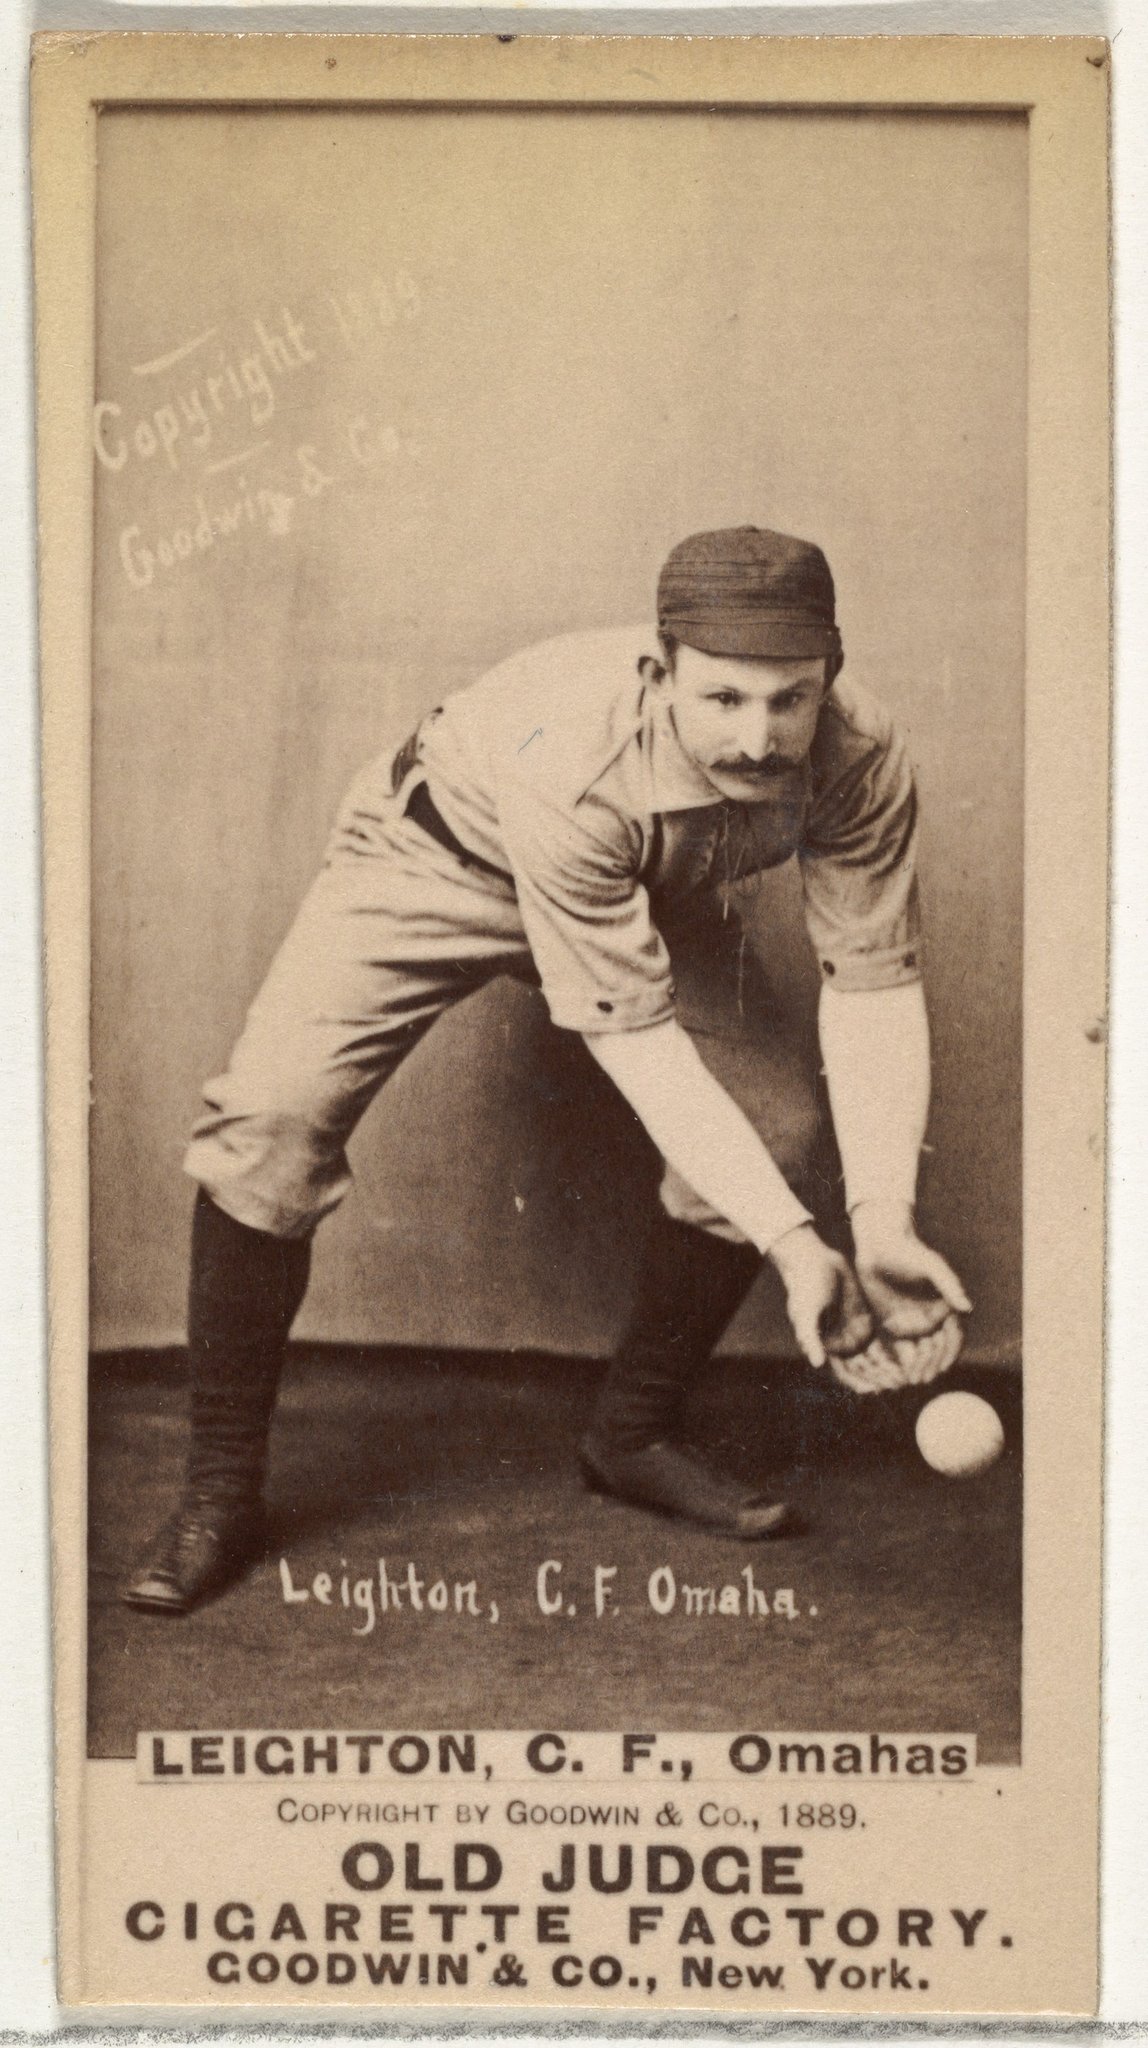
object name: baseball card, photograph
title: Leighton, Center Field, Omaha Omahogs/ Lambs, from the Old Judge series (N172) for Old Judge Cigarettes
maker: goodwin & company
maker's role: publisher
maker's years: 1850-1950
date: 1889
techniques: albumen silver print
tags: men,portraits,baseball,athletes